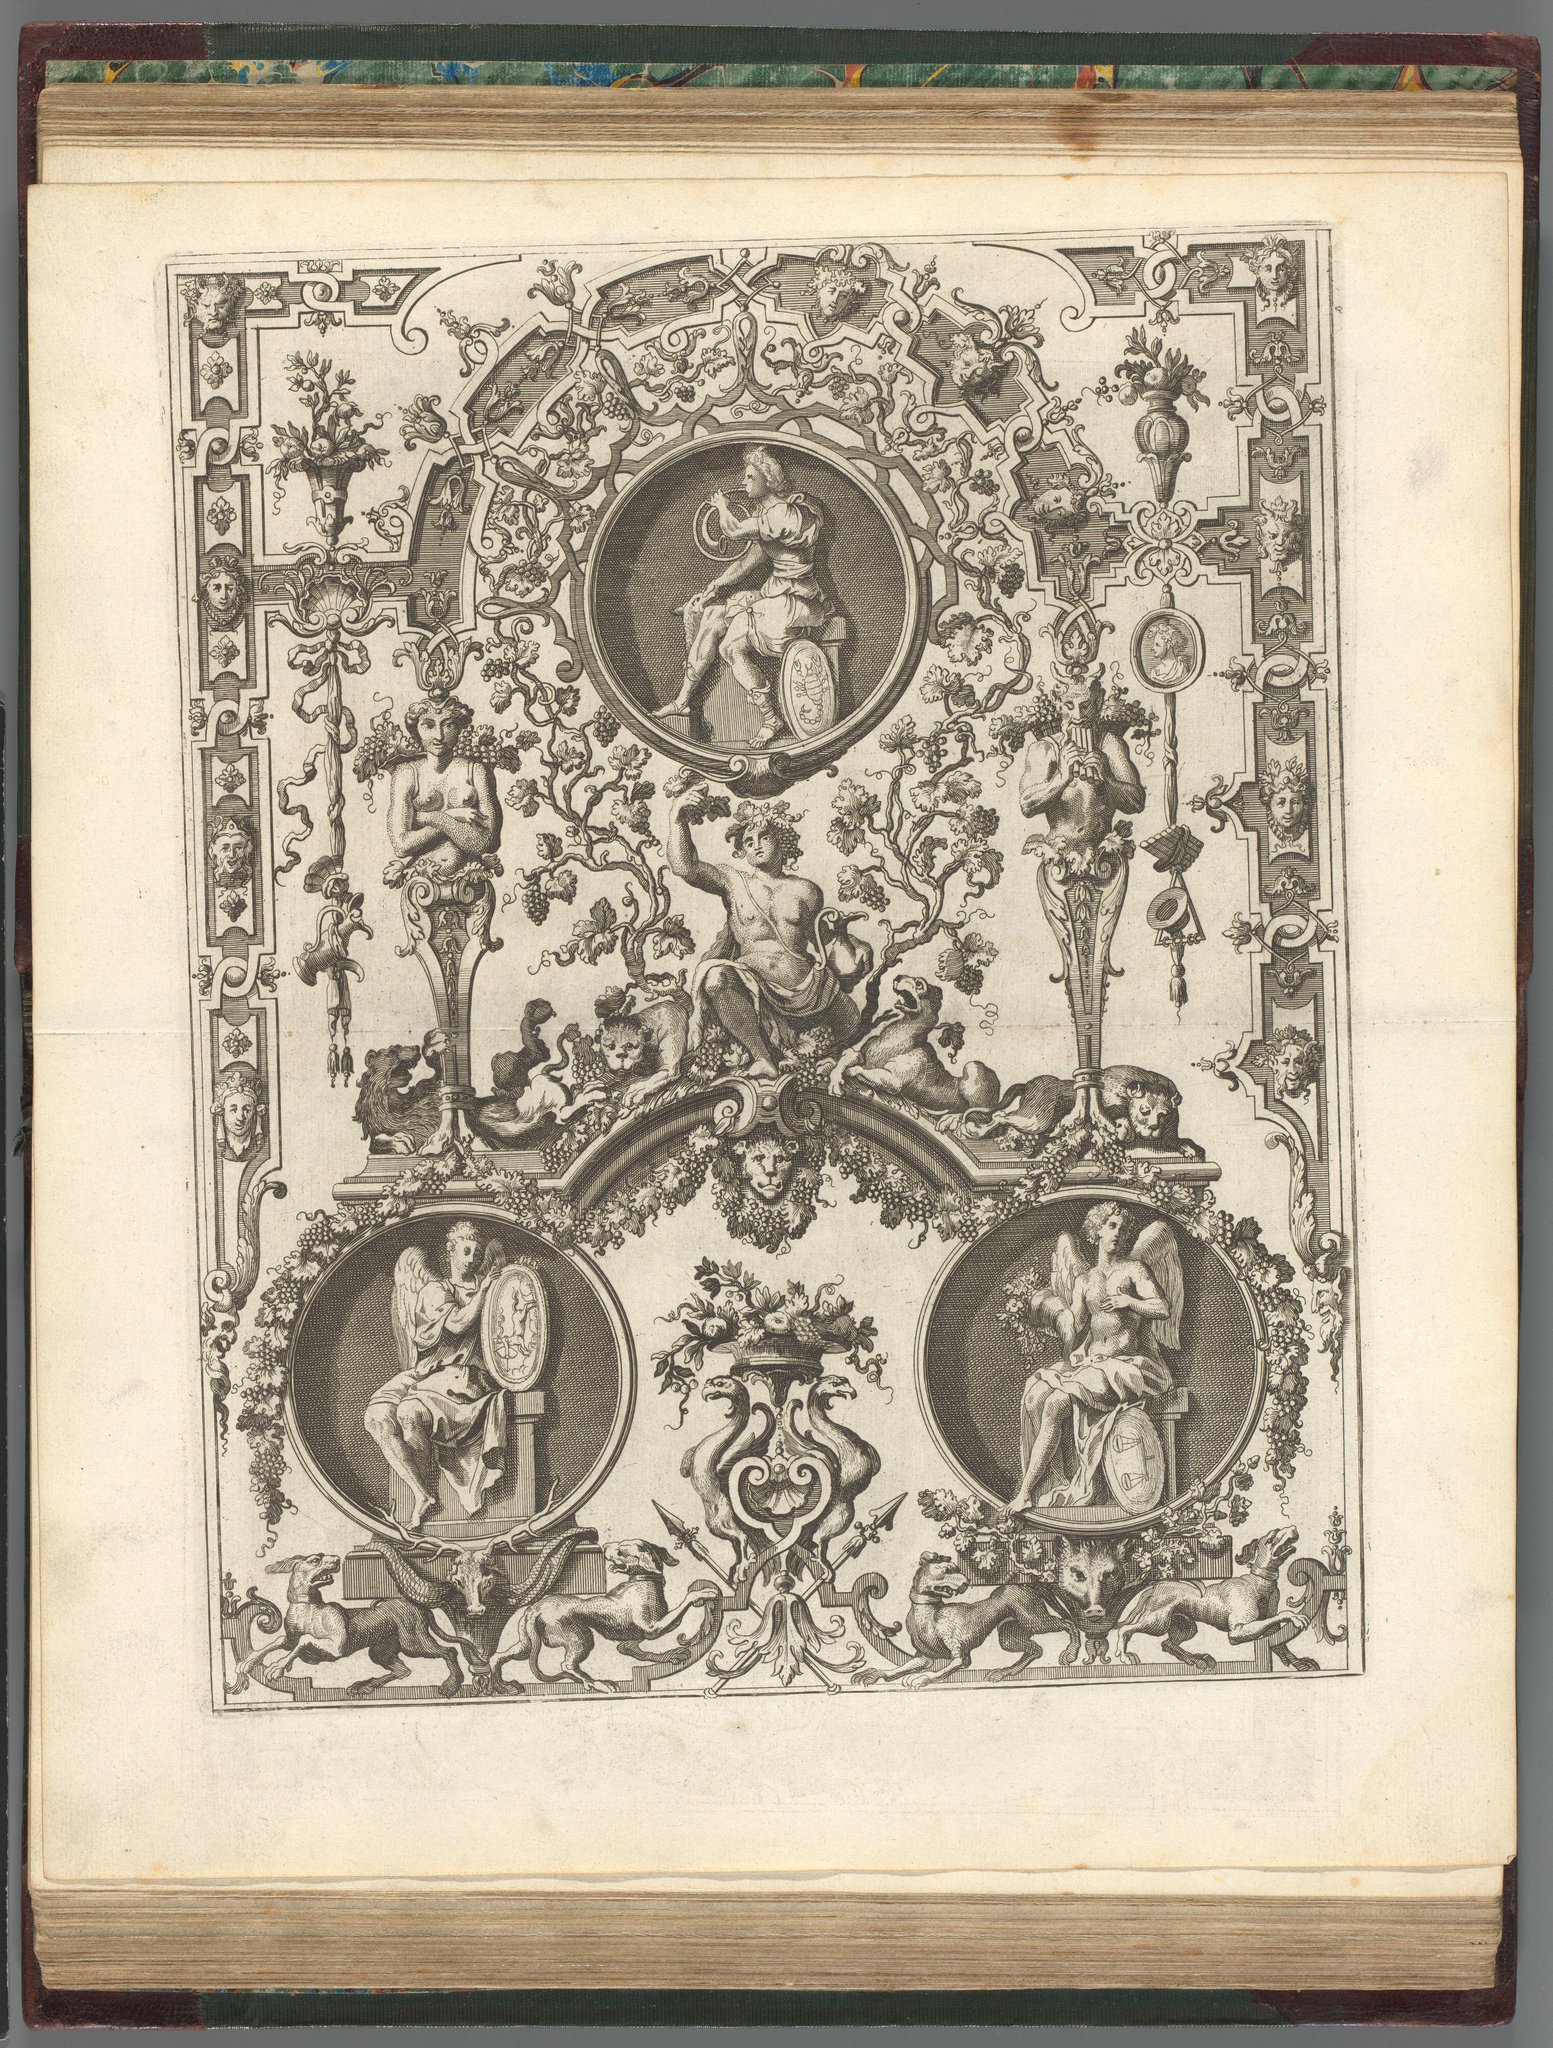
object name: album leaf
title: Herfst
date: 1686-1724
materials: paper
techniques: etching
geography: augsburg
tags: 'cornucopia', horn of plenty, ornaments ~ art, ornament ~ medallion, autumn, fall, 'autumnus'; 'autunno' (ripa)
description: Allegorische voorstelling van de herfst. Een decoratieve compositie met drie medaillons met personificaties van de maanden september, oktober en november met bijbehorende tekens van de dierenriem. In het midden op een arcade zit Bacchus omgeven door wijnranken tussen twee kariatiden. Aan weerszijden van Bacchus liggen katachtigen. Onder de arcade wordt een vaas gedragen door twee adelaars. Aan de onderzijde vier honden. Prent maakt deel uit van een album. Hoogstwaarschijnlijk gespiegelde kopie naar Frans origineel.